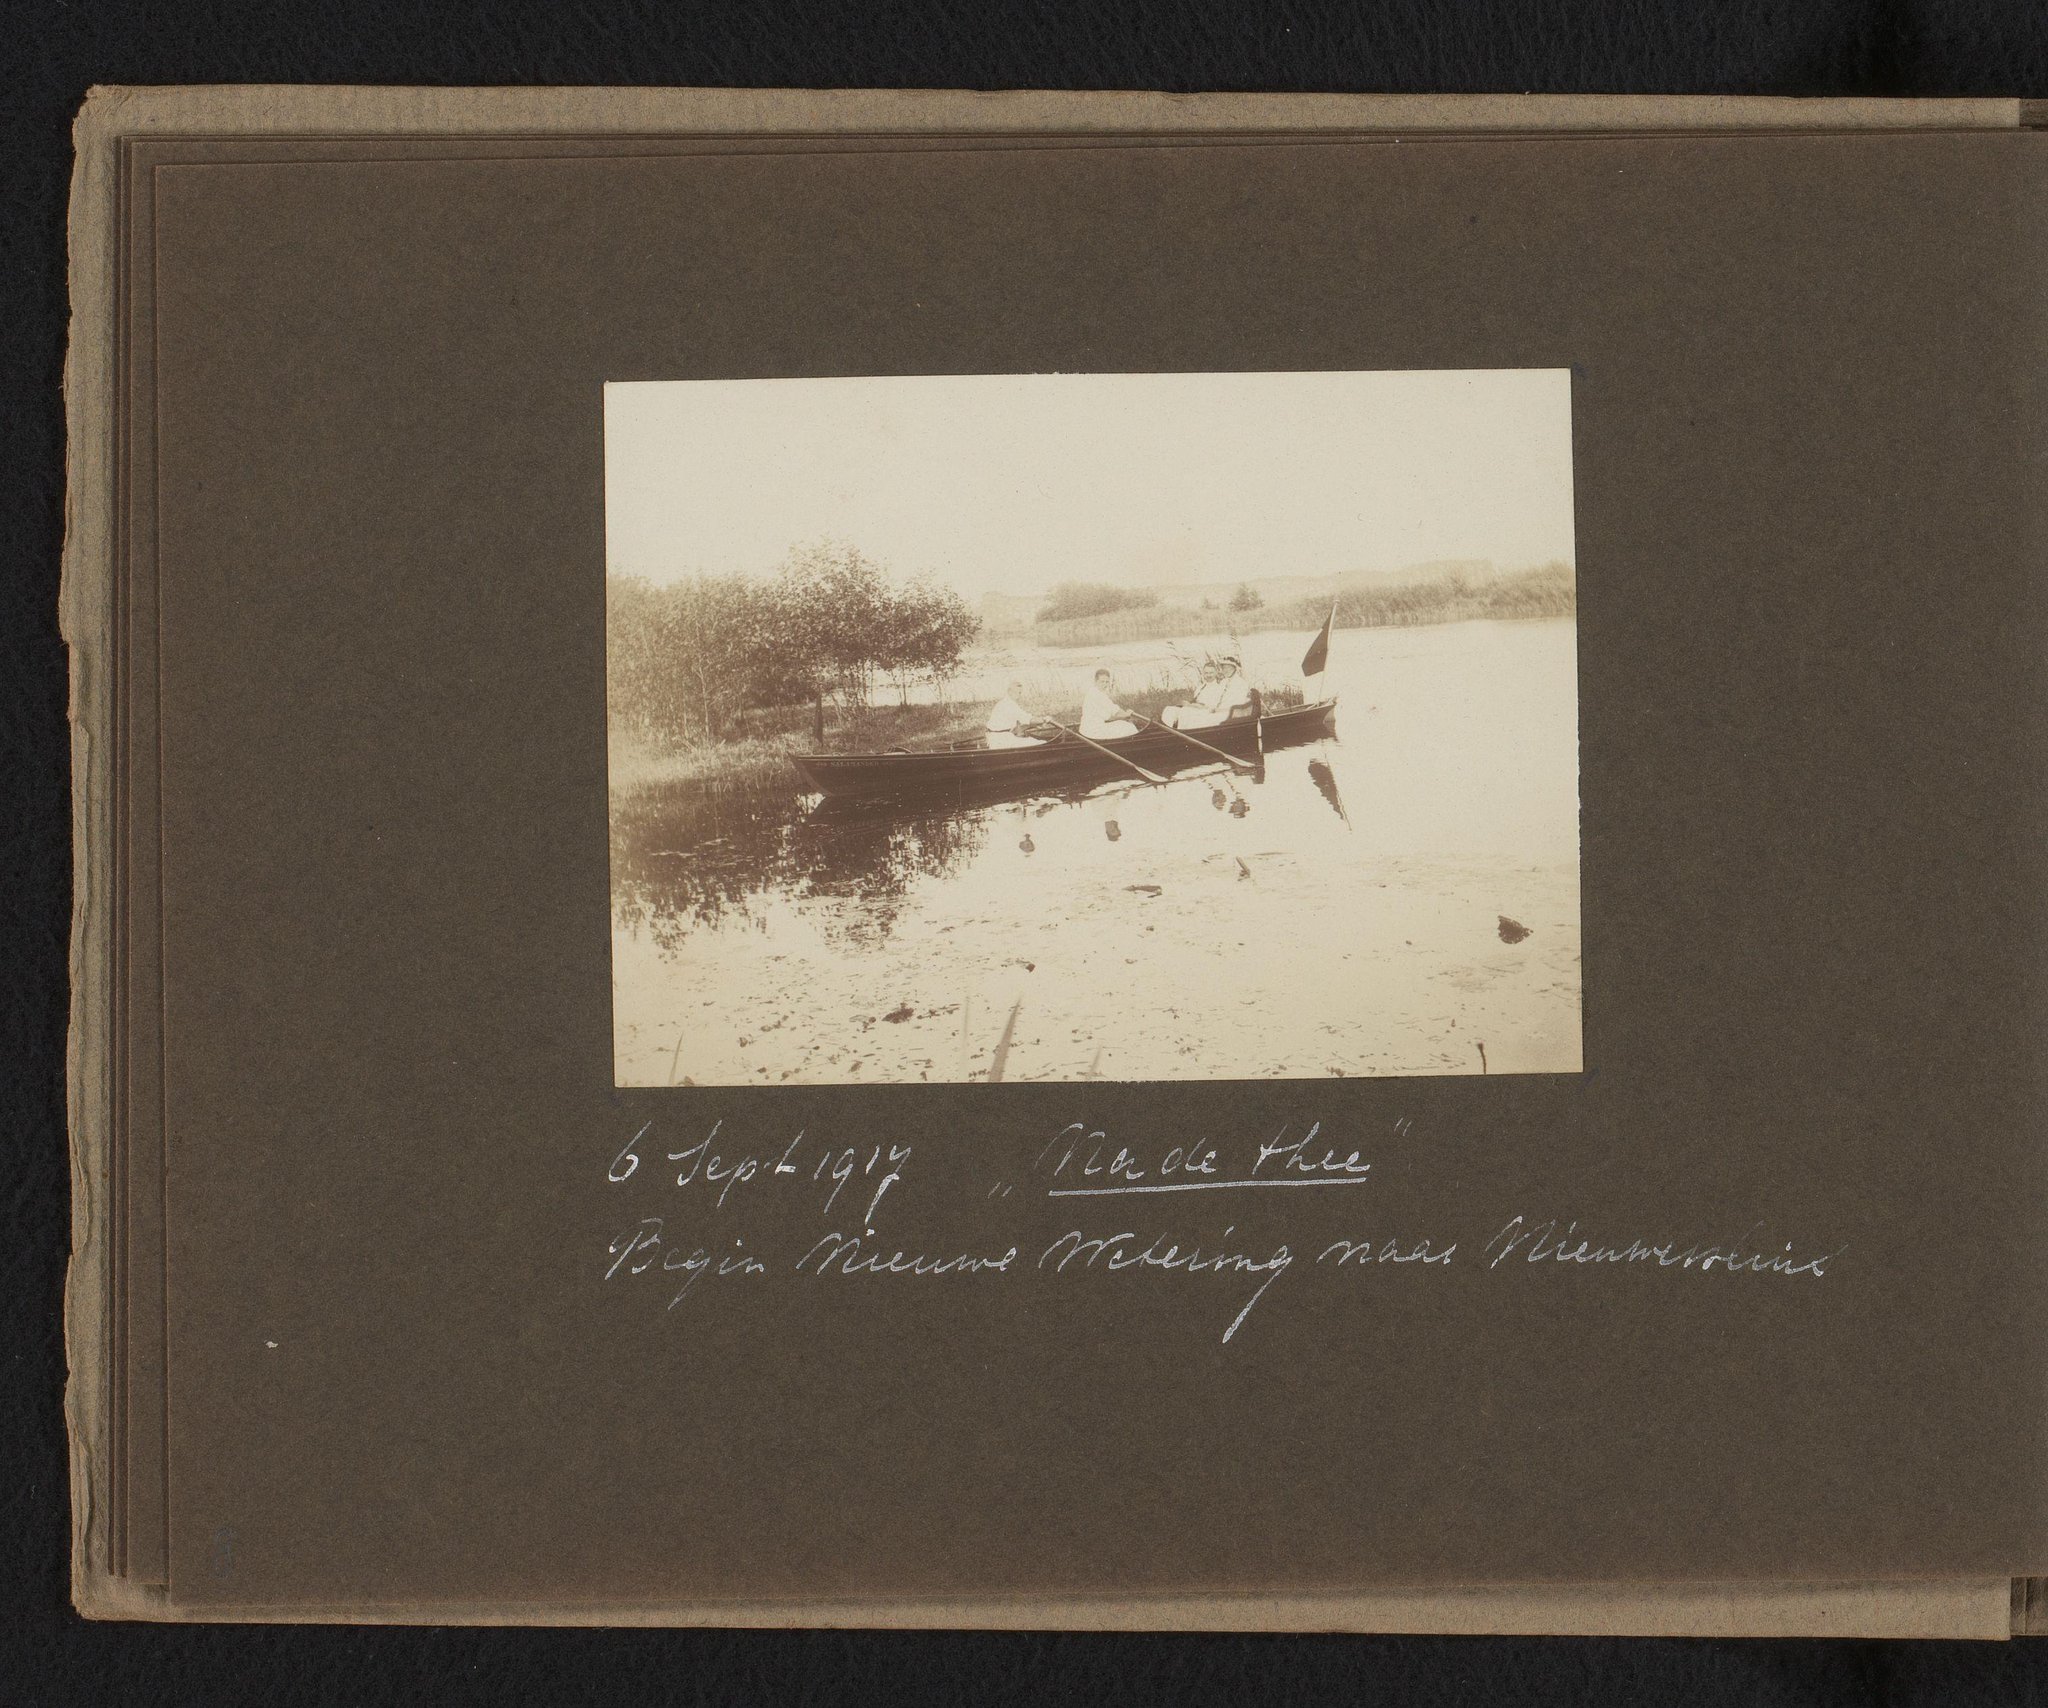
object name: album leaf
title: Drie mannen en een vrouw in een roeiboot op de Nieuwe Wetering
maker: Anonymous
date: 1917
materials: paper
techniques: matte daylight collodion silver print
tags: adult man (+ three persons), adult woman, river, rowing-boat, canoe, etc.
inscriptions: caption: ‘"Na de thee"/ Begin Nieuwe Wetering naar Nieuwesluis’